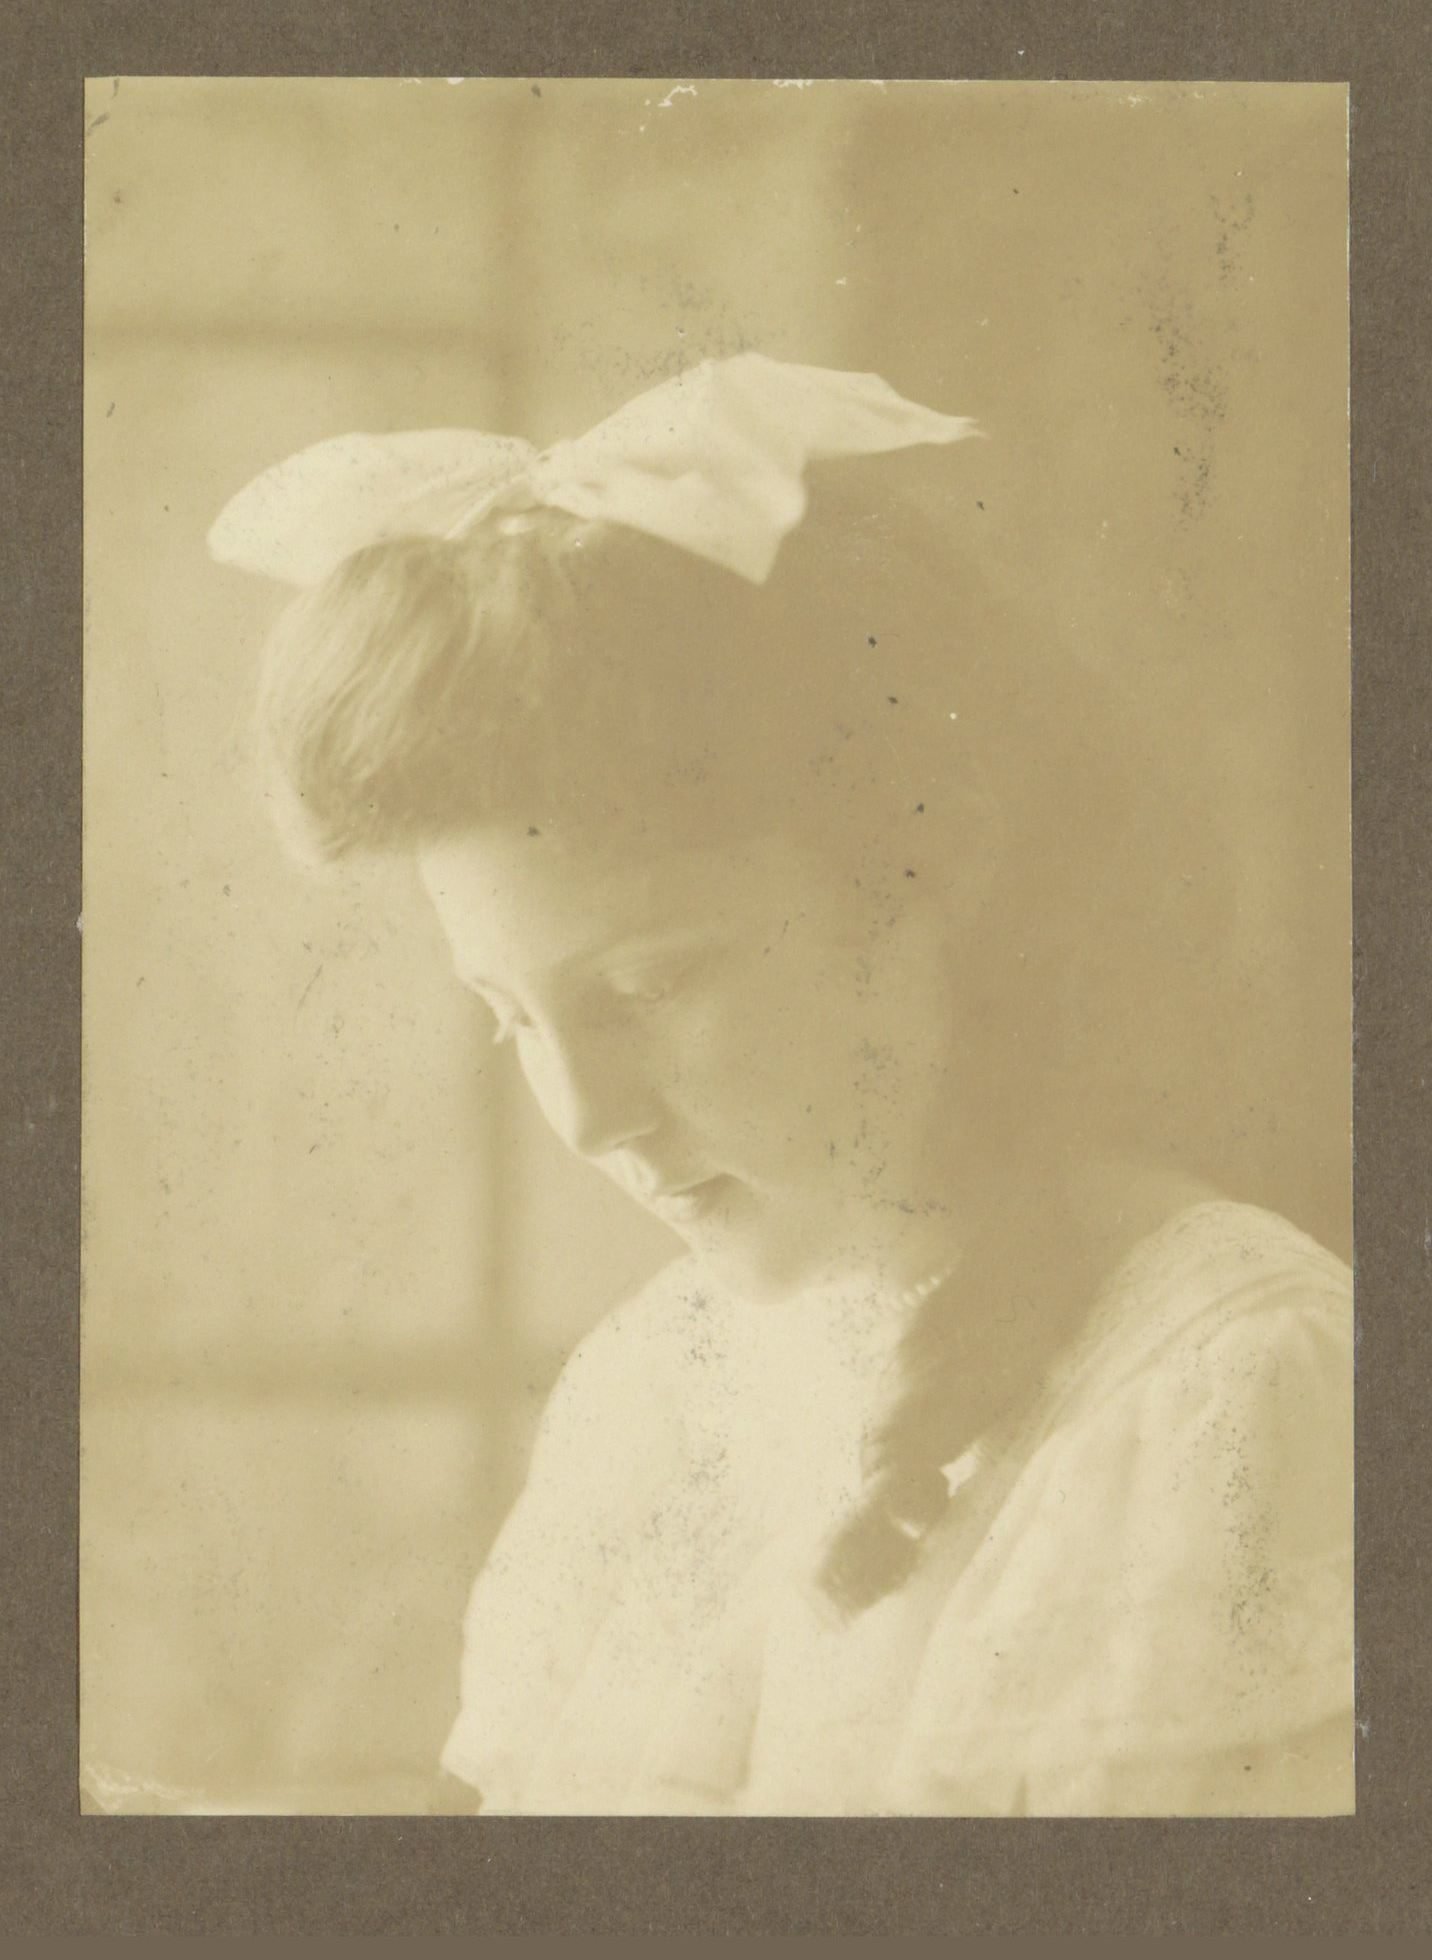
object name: photograph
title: Portret van een vrouw met een strik in het haar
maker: cornelis johannes lodewicus vermeulen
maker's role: fotograaf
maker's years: 1861-1936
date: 1900-1920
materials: paper, photographic support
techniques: albumen print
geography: the hague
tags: adult woman, border, ribbon, braid, the hague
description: Onderdeel van Fotoalbum met opnames van het gezin en het huis van fotograaf C.J.L. Vermeulen in Den Haag.